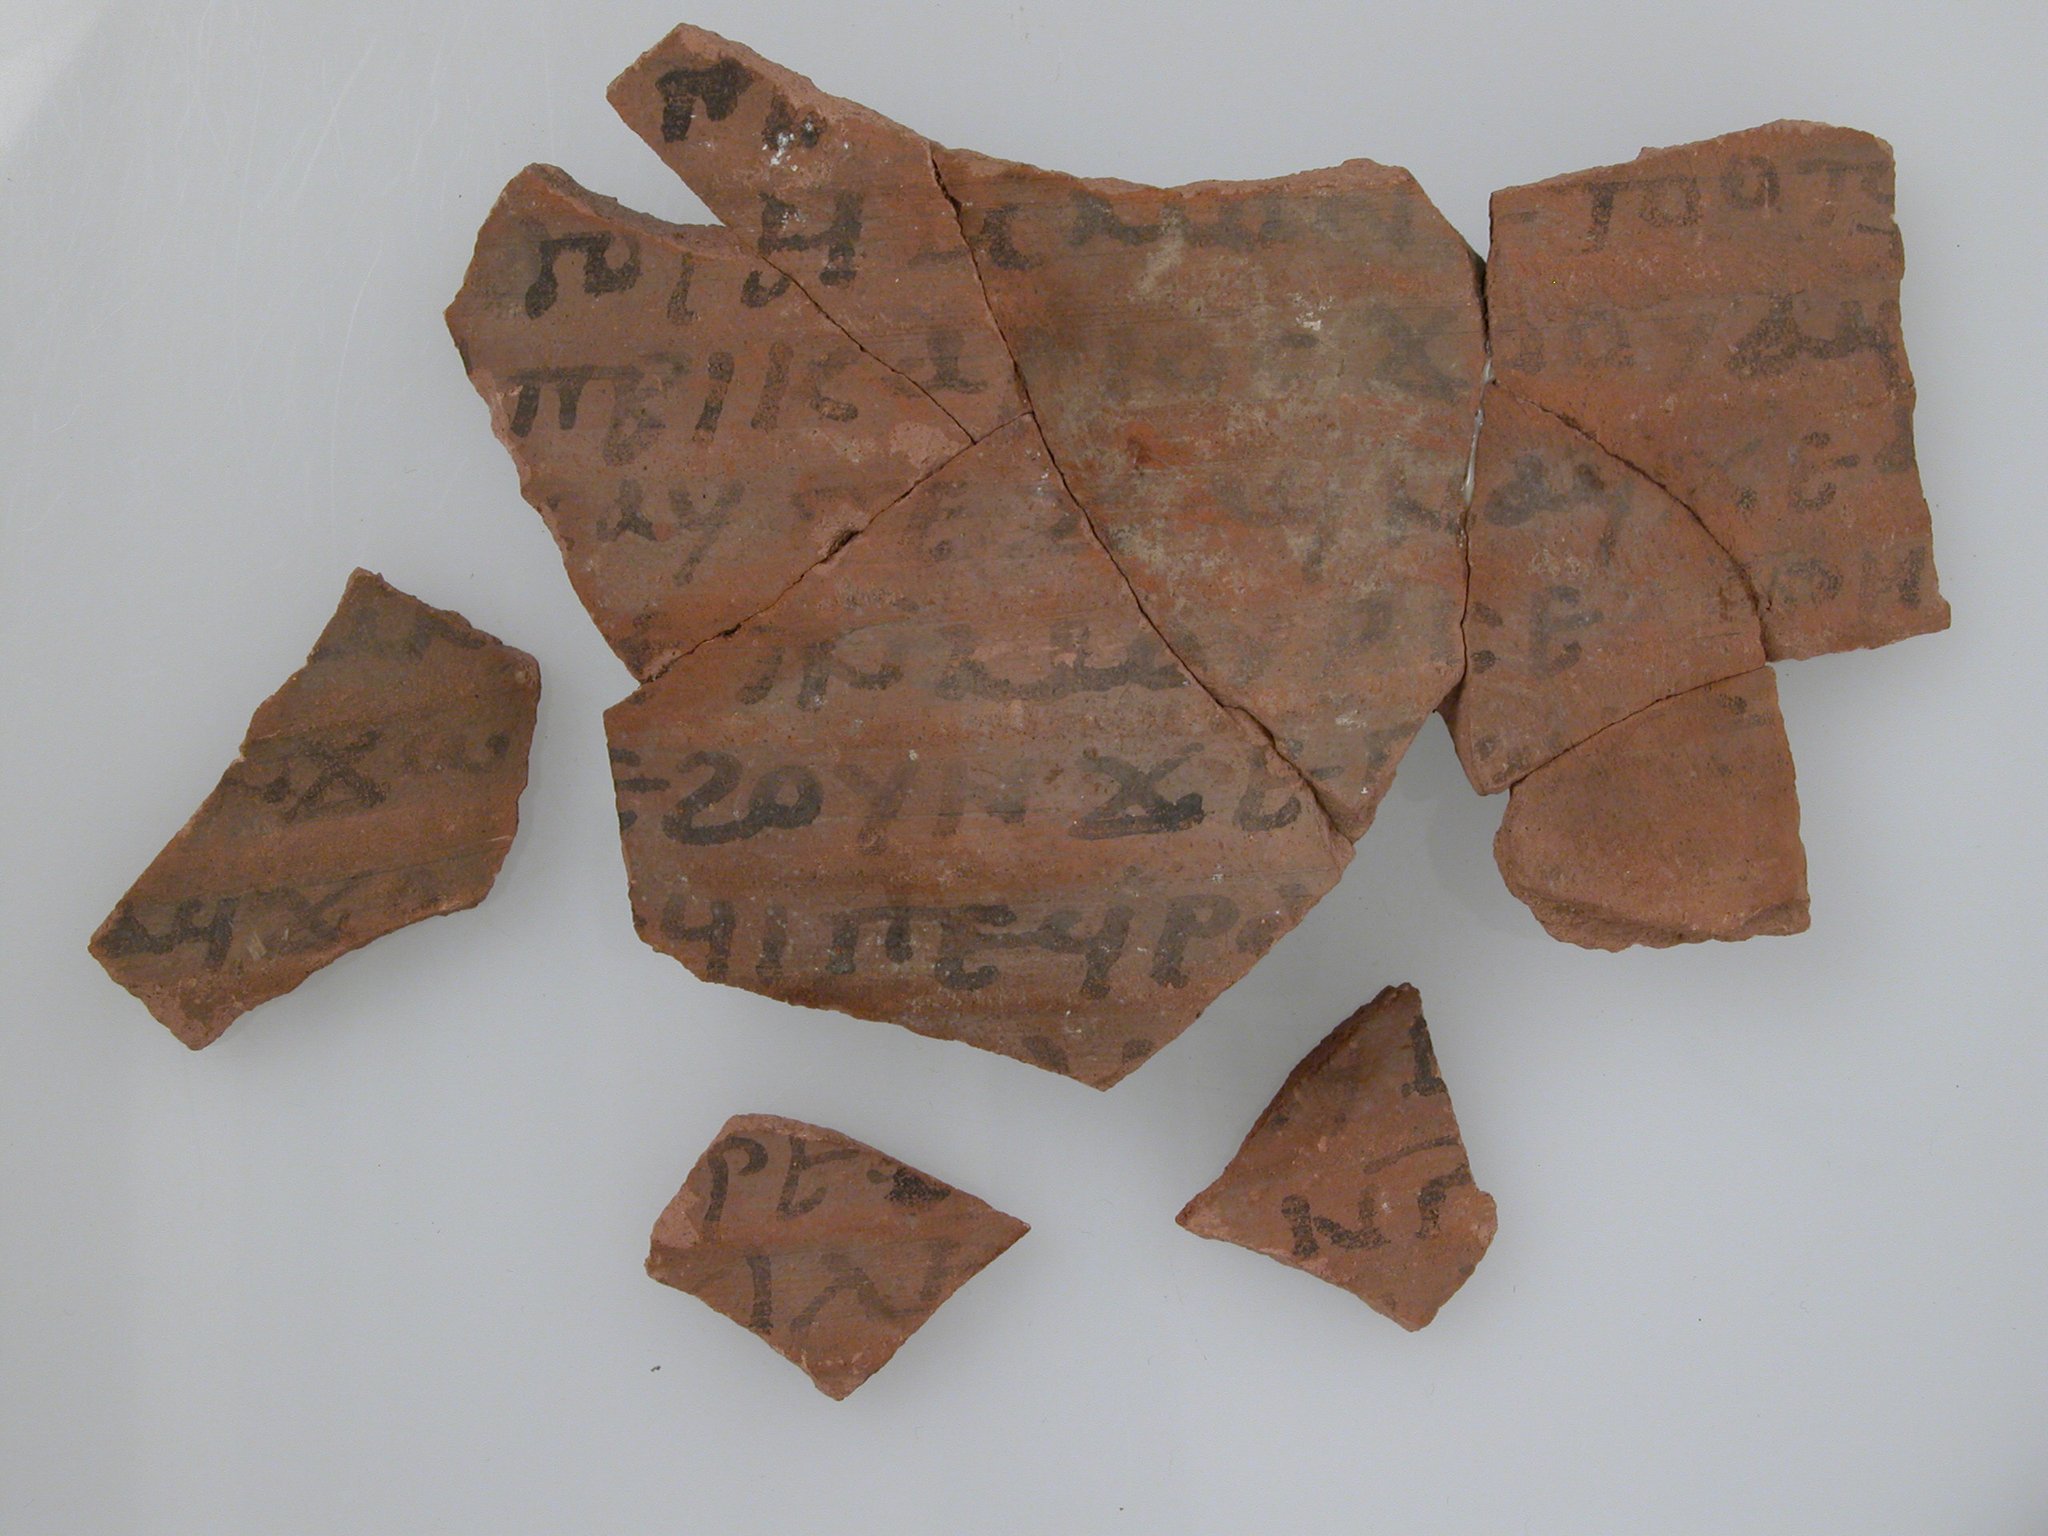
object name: ostrakon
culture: coptic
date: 580-640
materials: ink, pottery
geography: egypt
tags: coptic,documents